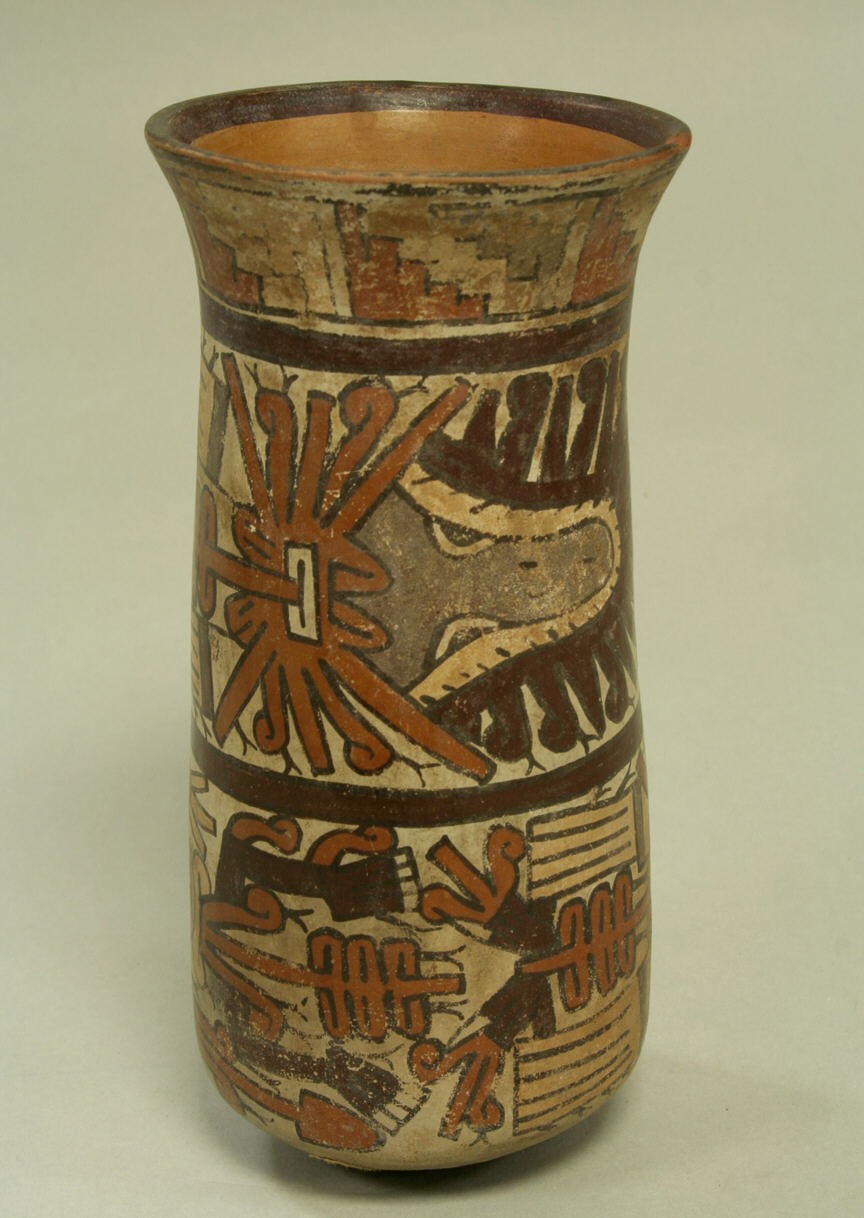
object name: beaker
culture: nasca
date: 401-700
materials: ceramic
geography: peru